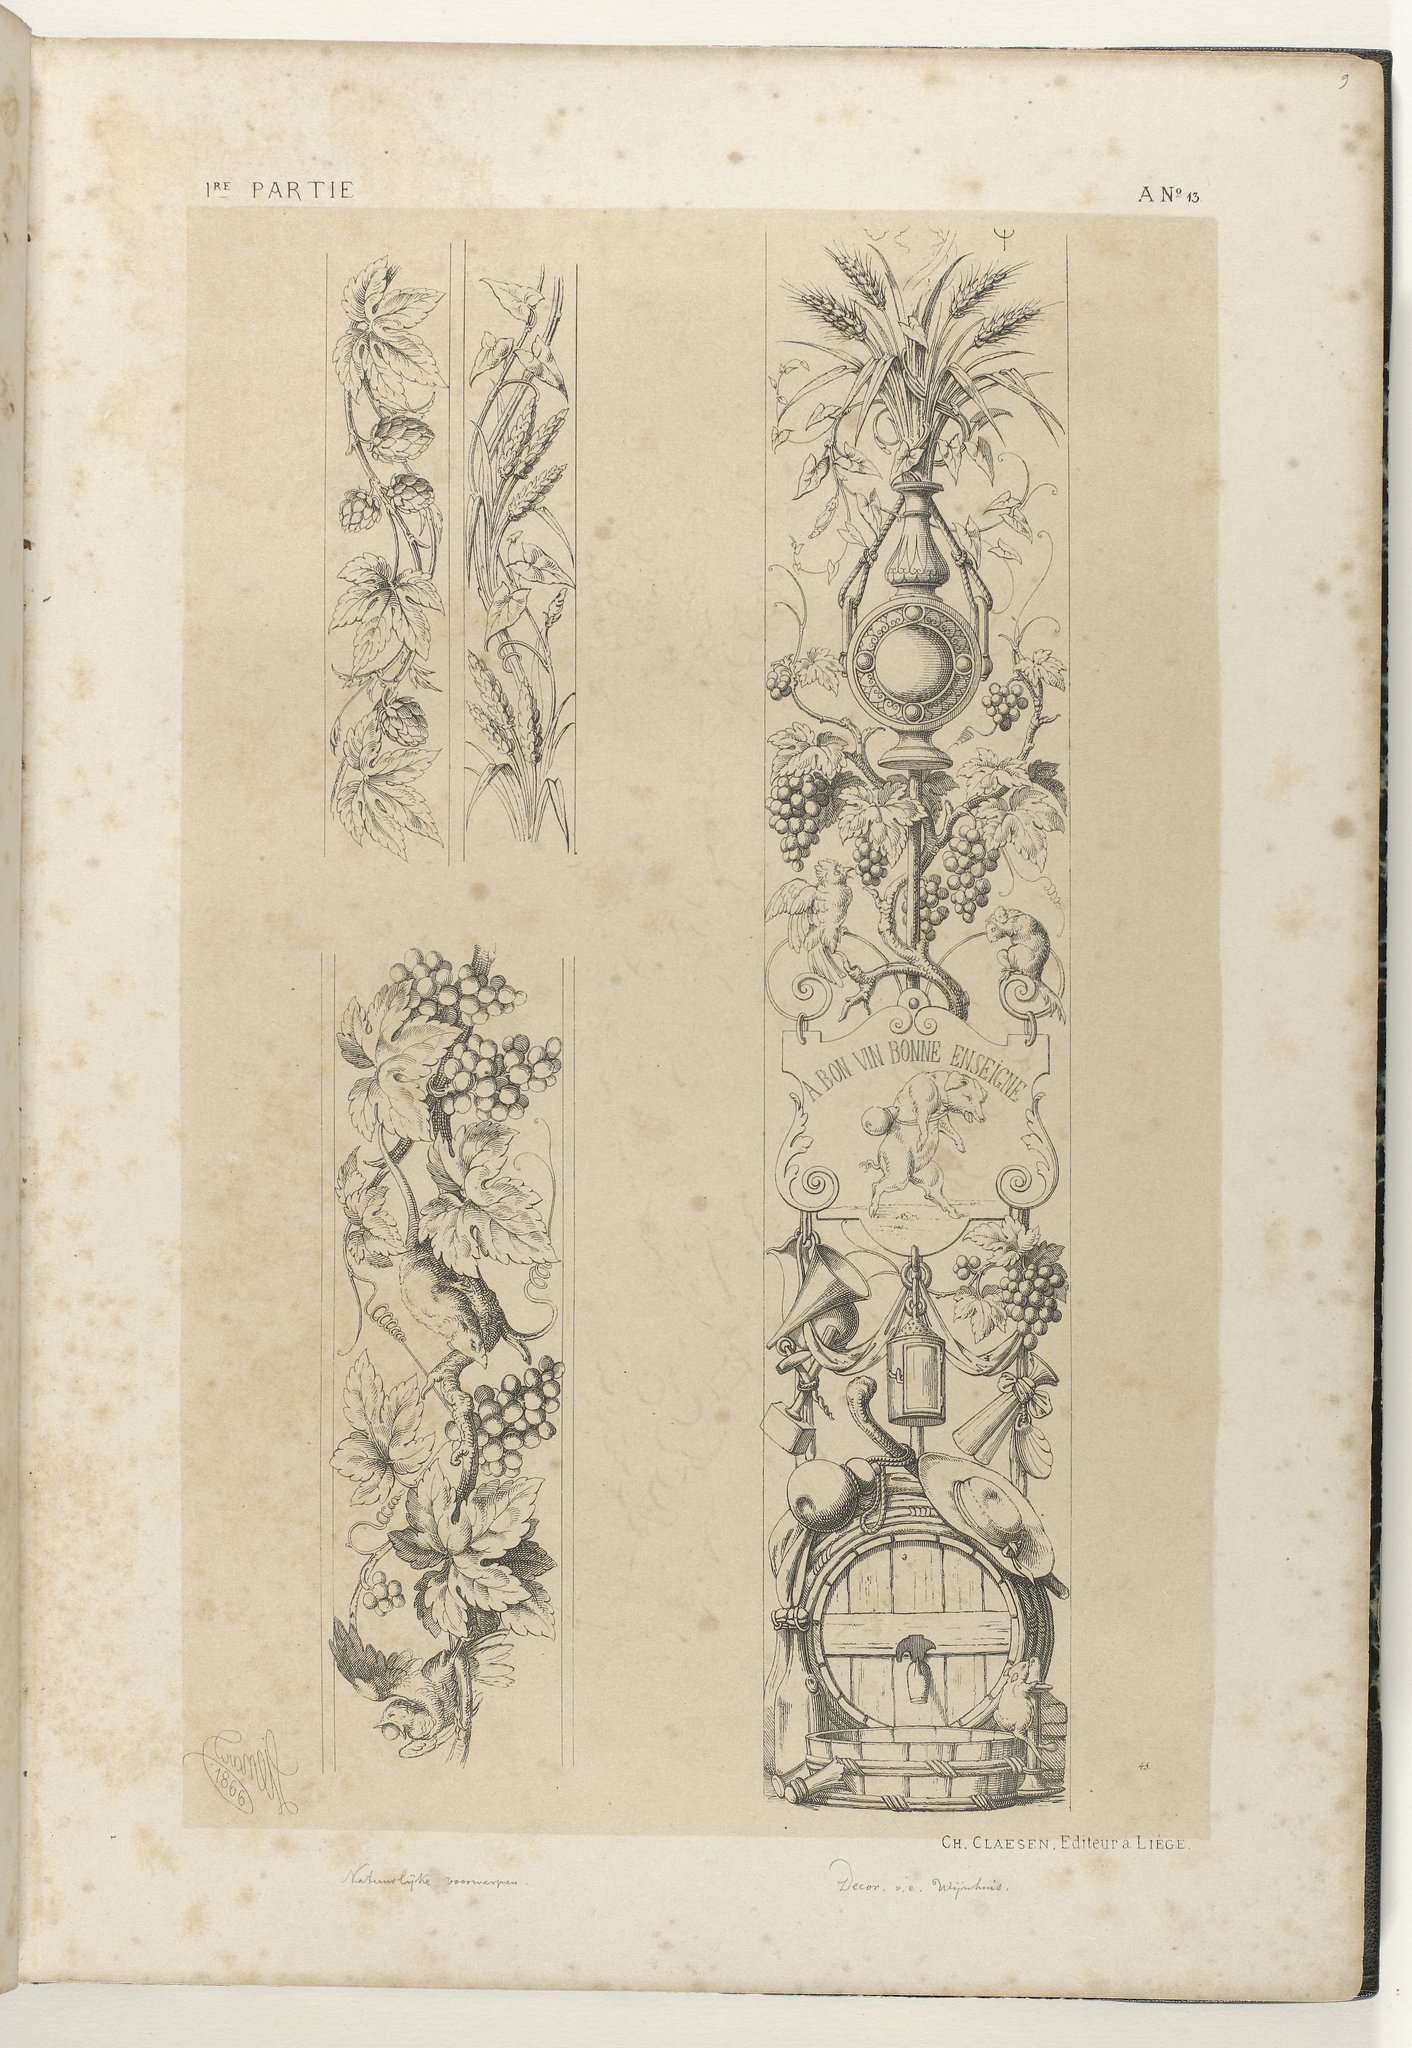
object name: print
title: Drie friezen en een kandelaber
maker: michel liénard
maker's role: print maker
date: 1866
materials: paper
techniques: tone lithography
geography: liège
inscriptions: annotation: ‘Decor v.e. wijnhuis.’, annotation: ‘Natuurlijke voorwerpen’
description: Links drie friezen met wijnranken, hop en graan, rechts een kandelaber met onderaan een wijnvat en in het midden een bord met de tekst: A bon vin bonne enseigne. Linksboven: 1re partie, rechtsboven: A N° 13., rechtsonder: 45.